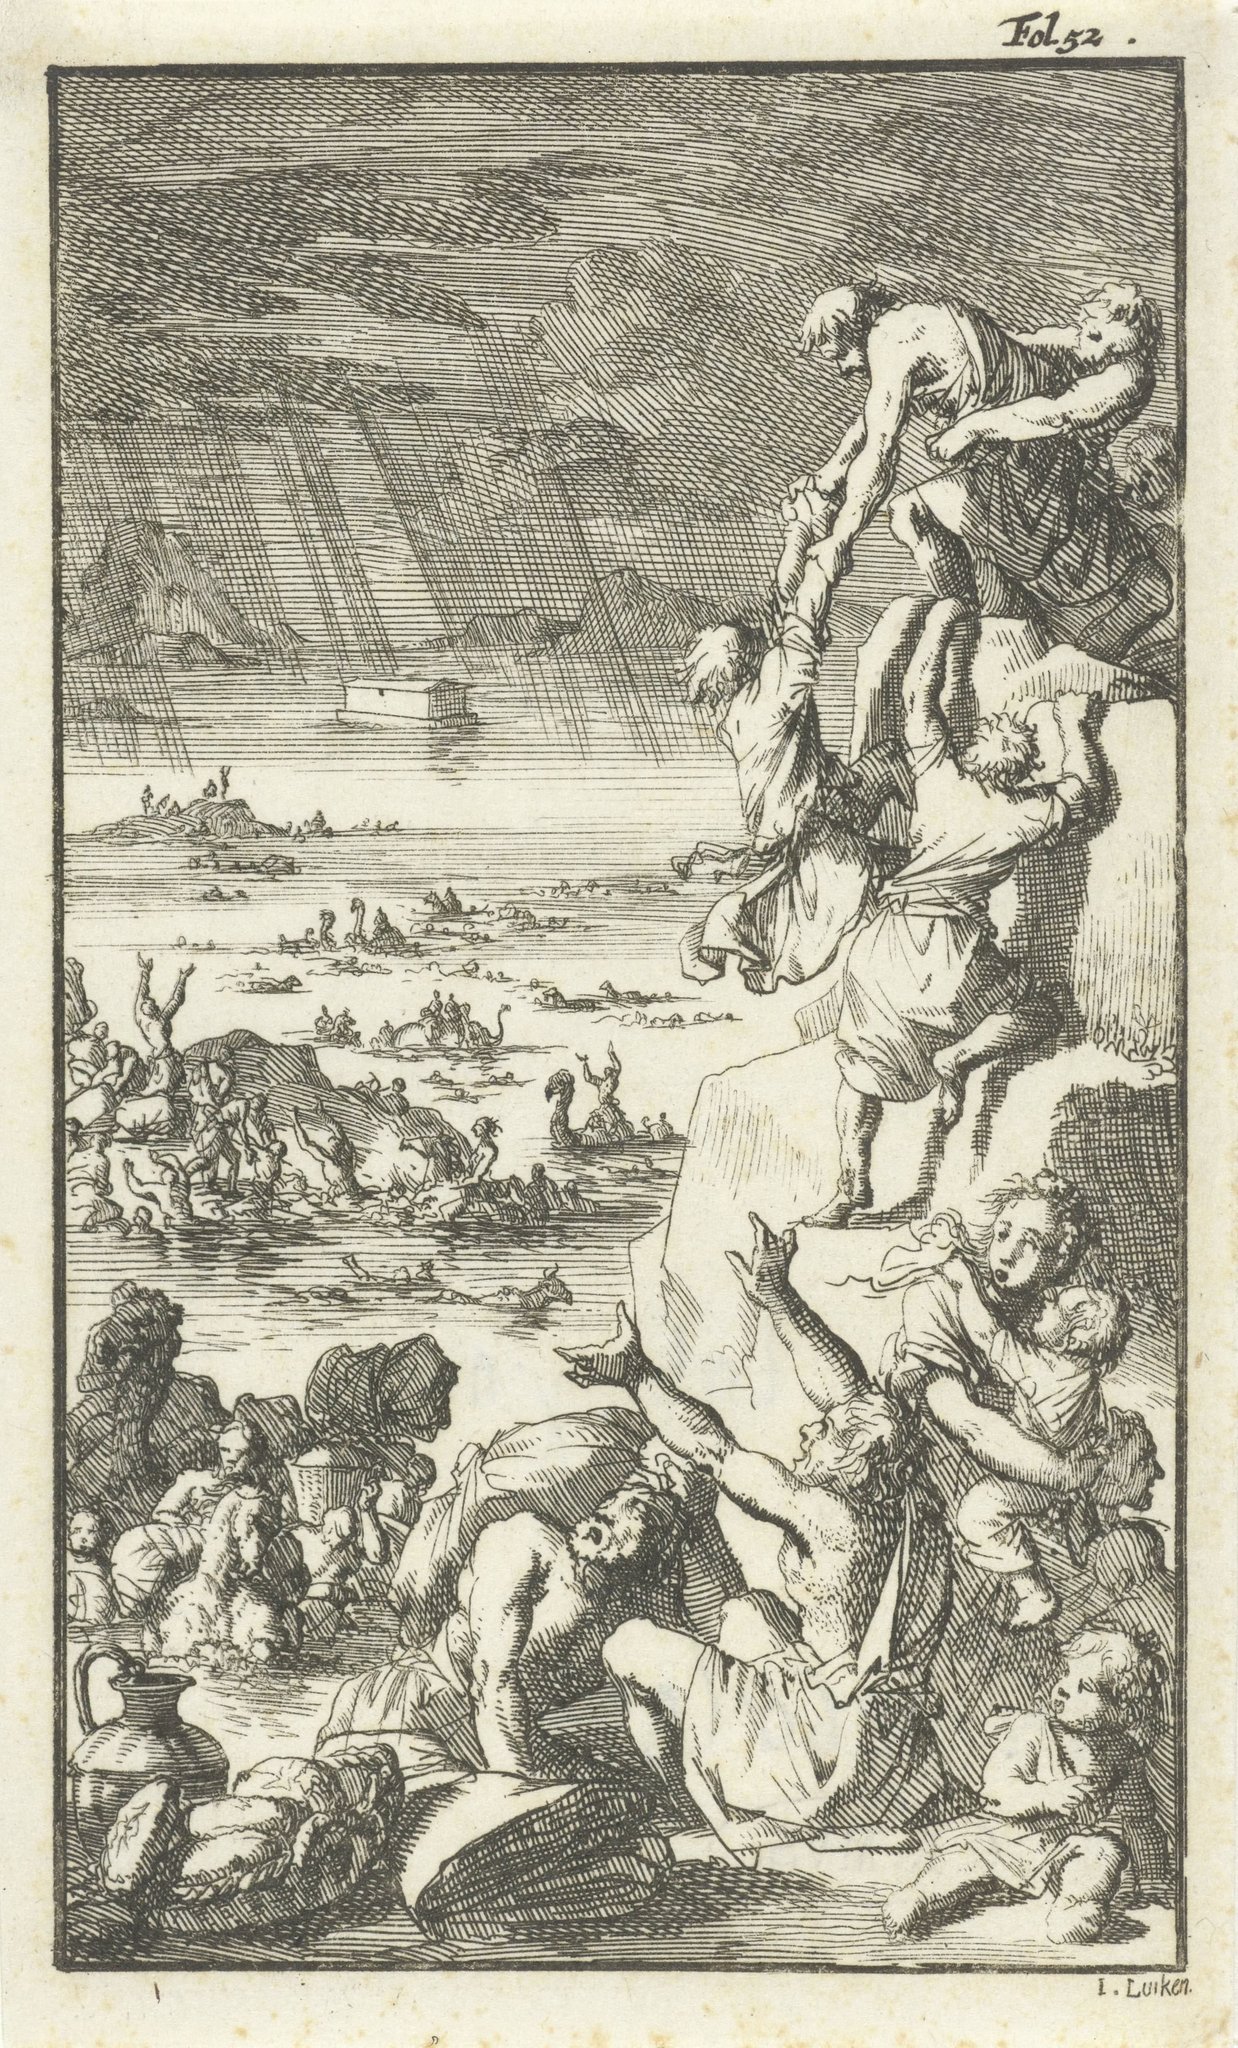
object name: book illustration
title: De zondvloed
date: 1694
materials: paper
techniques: etching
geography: amsterdam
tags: the flood and destruction of mankind ~ story of noah (genesis 7:10 - 8:17)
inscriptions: collector's mark: Lugt 2228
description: Illustratie uit: Ray, John. De werelt van haar begin tot haar einde. Rotterdam: Barent Bos, 1694.